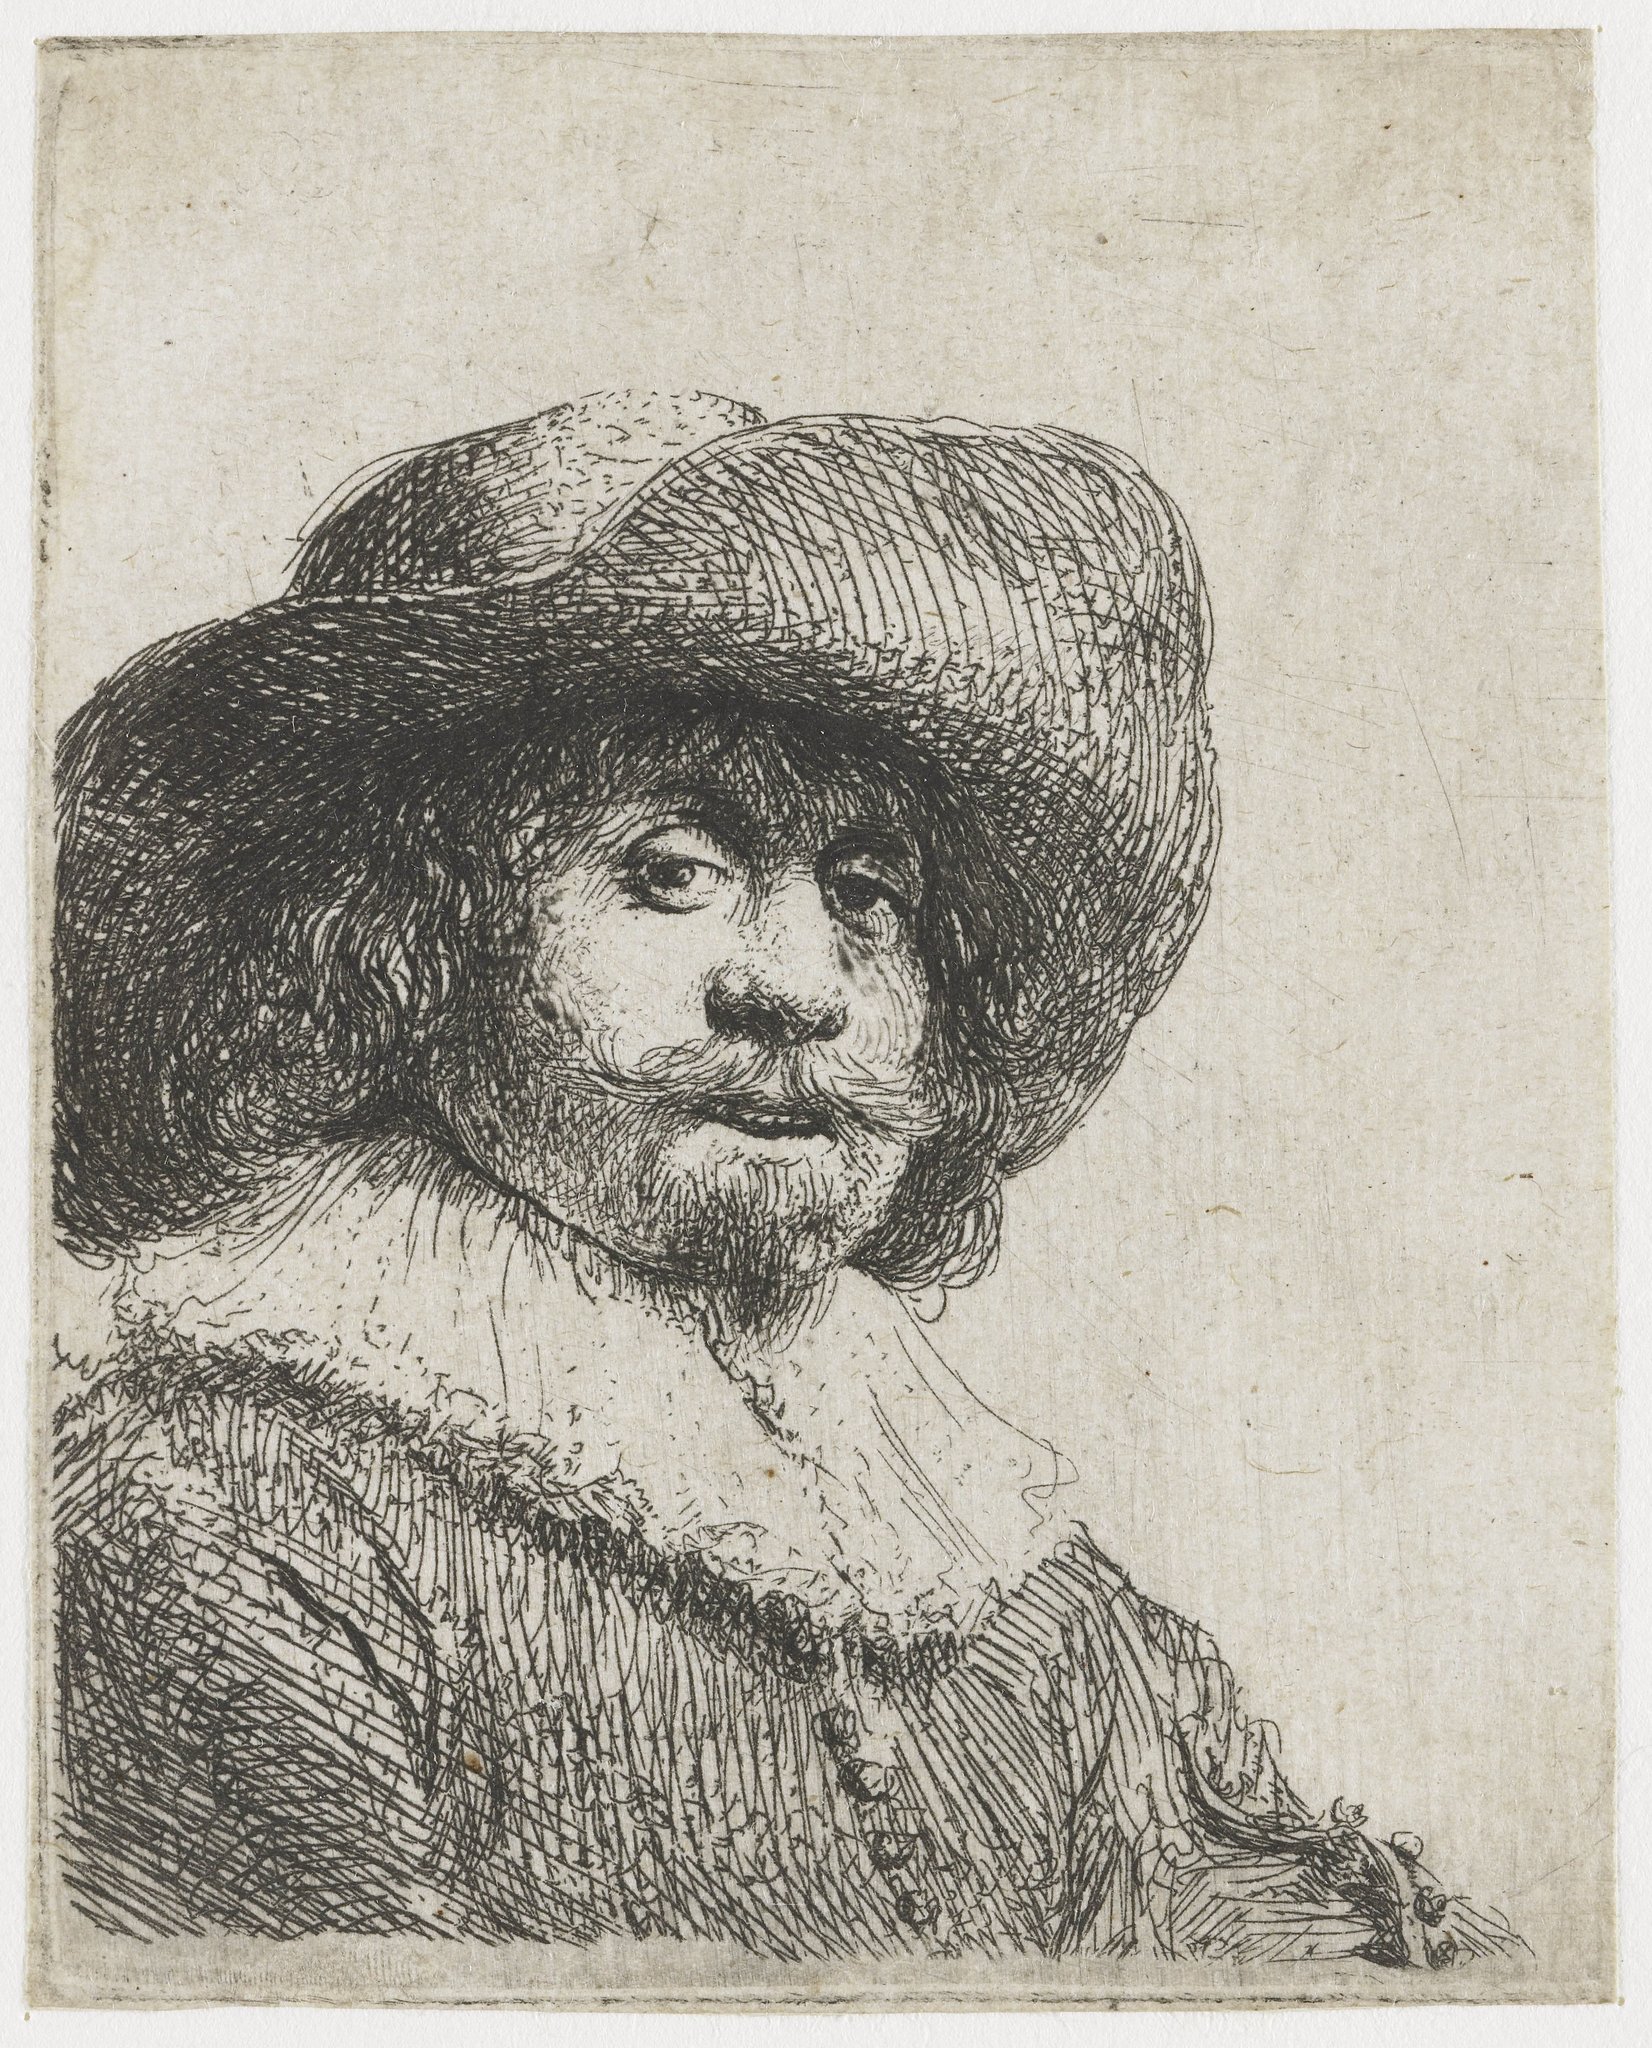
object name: print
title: Man in a broad-brimmed hat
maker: rembrandt van rijn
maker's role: draughtsman, painter, print maker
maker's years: 1606-1669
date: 1630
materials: paper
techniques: etching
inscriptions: collector's mark: Lugt 1962, monogram and date: ‘RHL 1638’, collector's mark: Lugt 2228